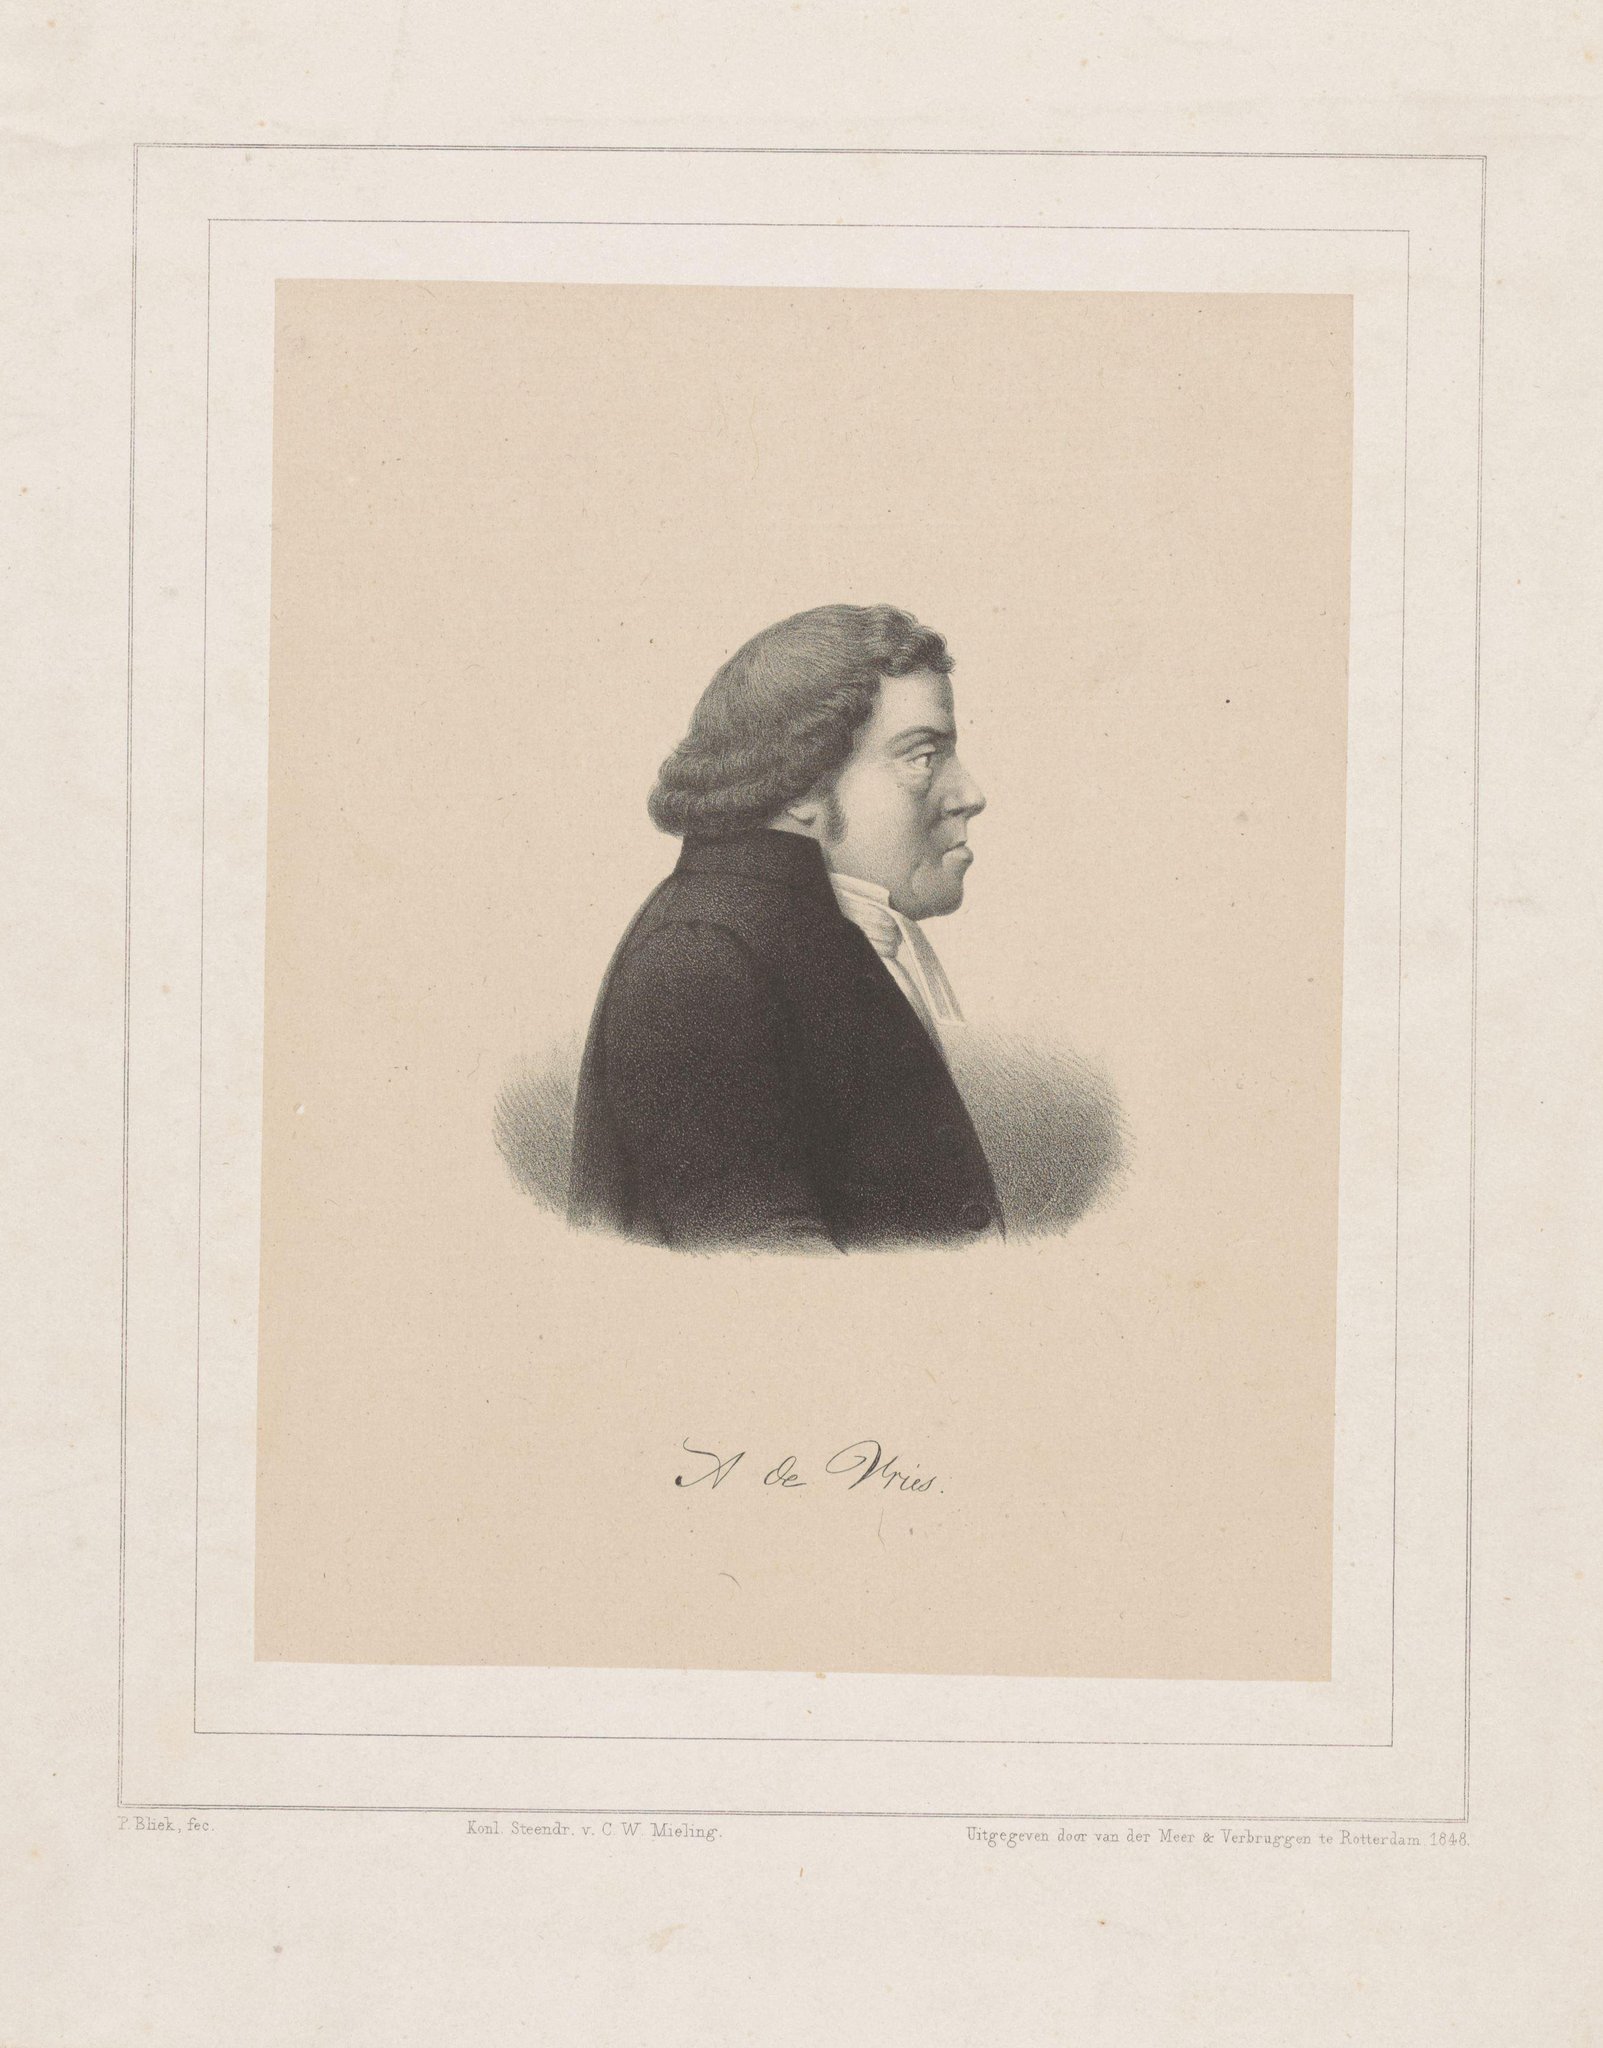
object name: print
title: Portret van Albertus de Vries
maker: pieter bliek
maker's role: print maker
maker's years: 1812-1853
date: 1848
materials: paper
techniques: lithograph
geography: rotterdam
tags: rotterdam, historical persons (+ profile portrait)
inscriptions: date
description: De geportretteerde kijkt naar rechts en is en profil weergegeven. Hij draagt een donkere jas en een witte bef. Onder het portret zijn signatuur.